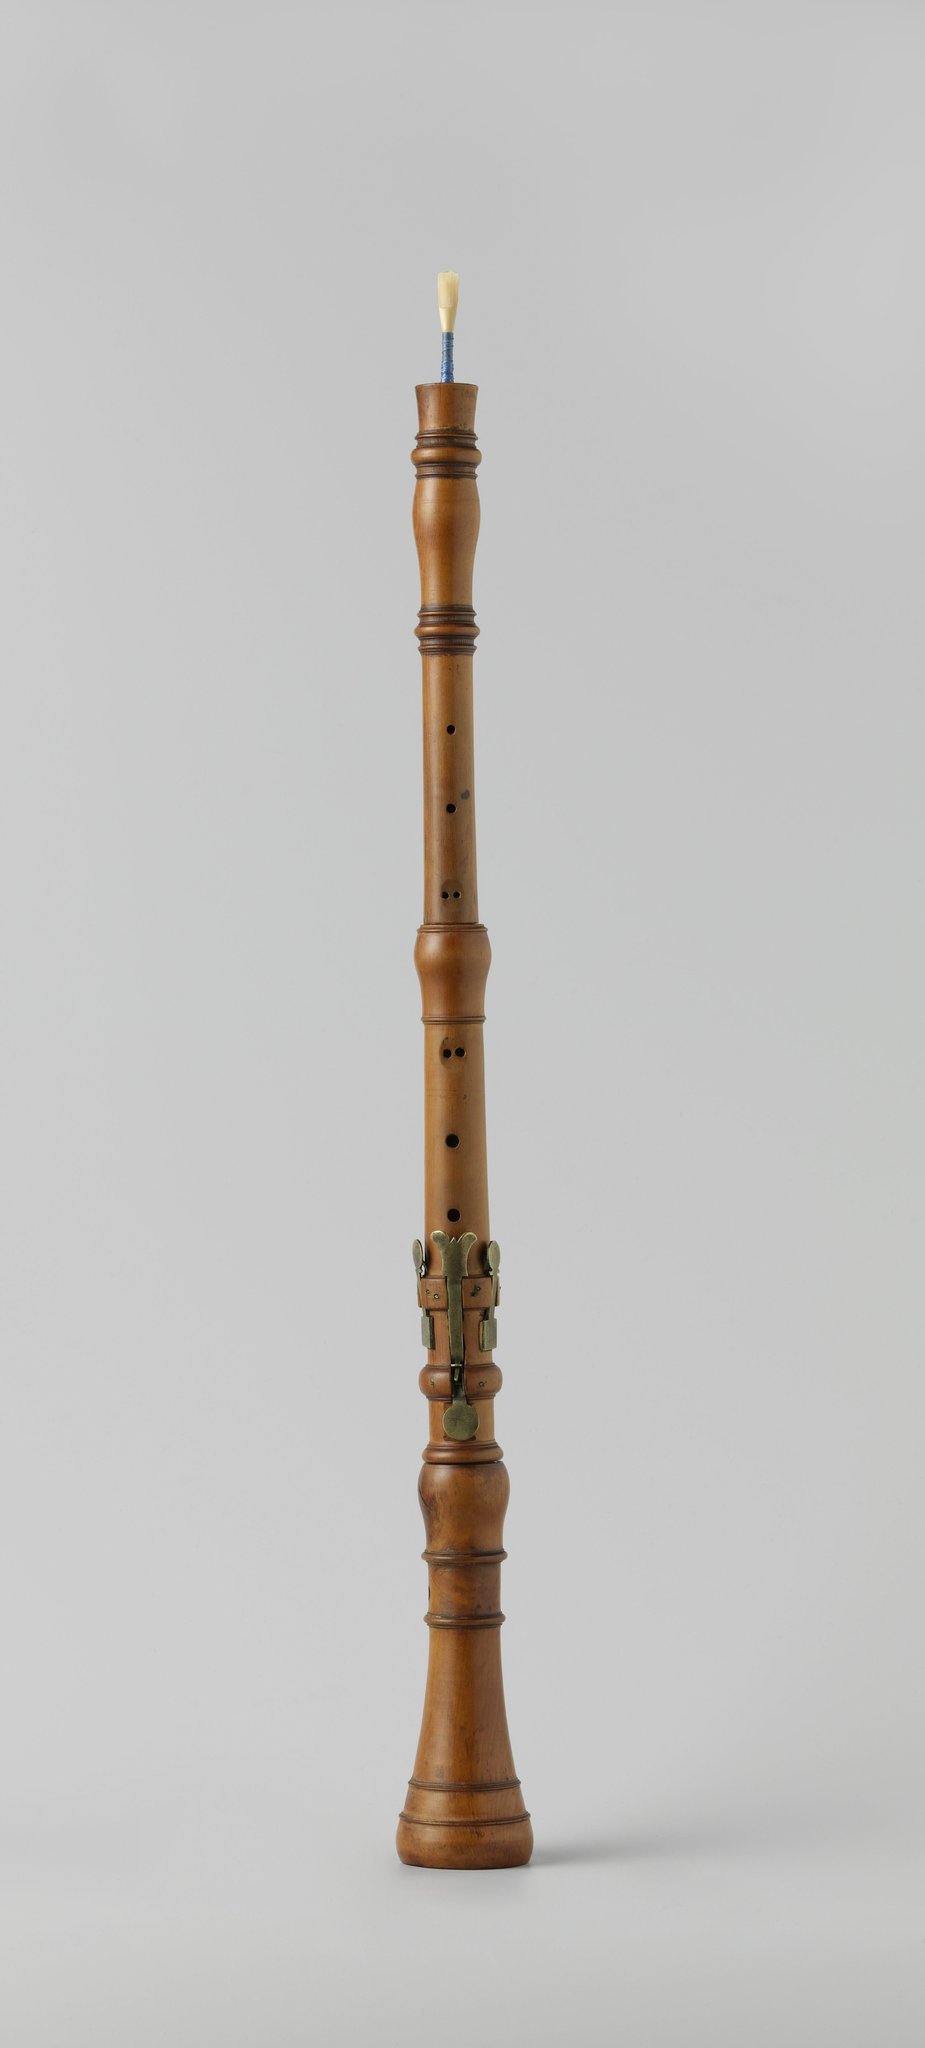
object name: musical instrument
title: Oboe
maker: d. lott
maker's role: musical instrument maker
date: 1750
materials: wood, brass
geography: germany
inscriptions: mark, On the middle joint, stamped: ‘D.LOTT’ [fleur-de-lis]/ D.LOTT/ [fleur-de-lis]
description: Hobo van blank buxushout met drie messing kleppen en acht gaten, waarvan het derde en vierde dubbel. Het instrument bestaat uit drie losse stukken.